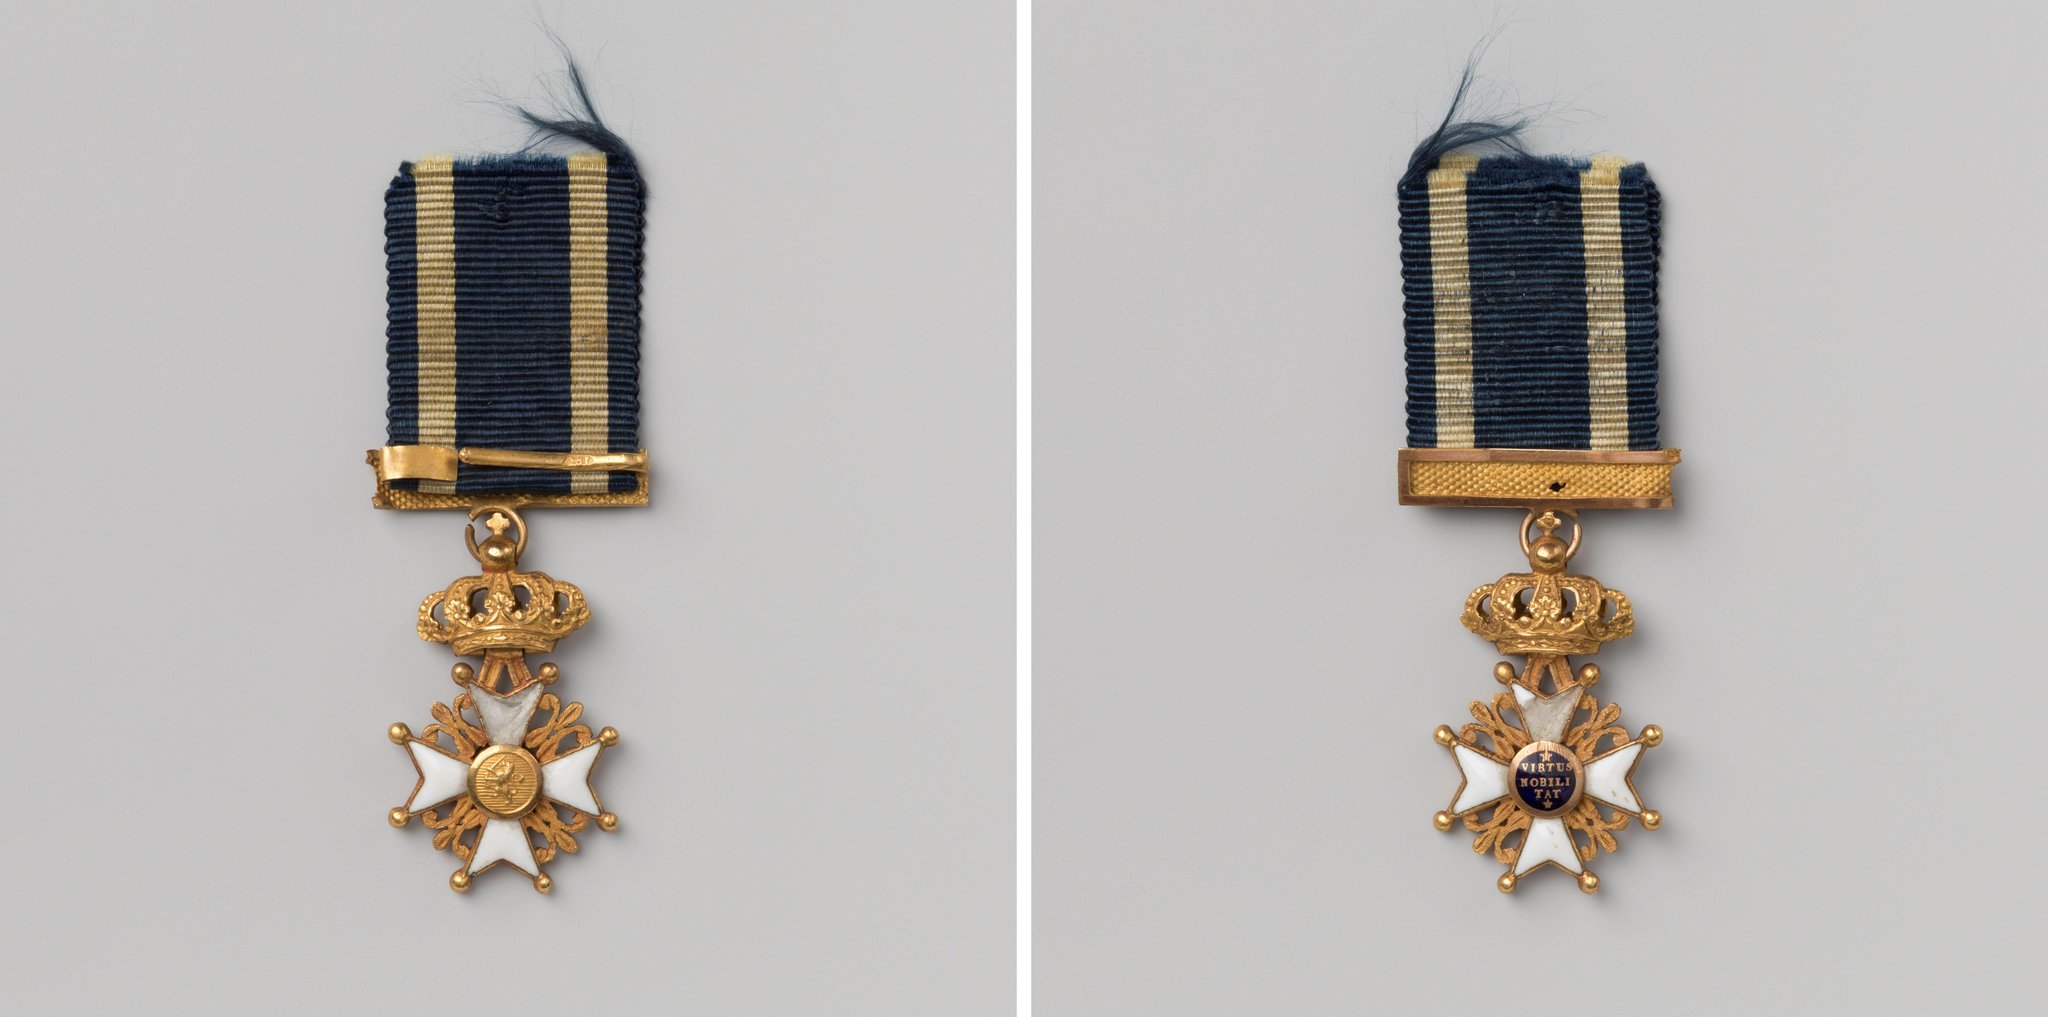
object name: pectoral cross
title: Orde van de Nederlandse Leeuw, ridder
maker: Anonymous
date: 1830-1840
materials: gold, textile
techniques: sawing, striking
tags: orde van de nederlandse leeuw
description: Klein formaat maltezer kruis met wit geëmailleerde armen en gouden balpunten. In hart aan voorzijde: medaillon met gekroonde leeuw met zwaard en pijlenbundel in goud; tussen de kruisarmen: sierlijk geschreven letter W in goud. In hart aan keerzijde: blauw geëmailleerd medaillon met gouden zoom en opschrift in goud, het geheel aan kroon, ring en blauw-oranje-blauw-oranje-blauw lint.